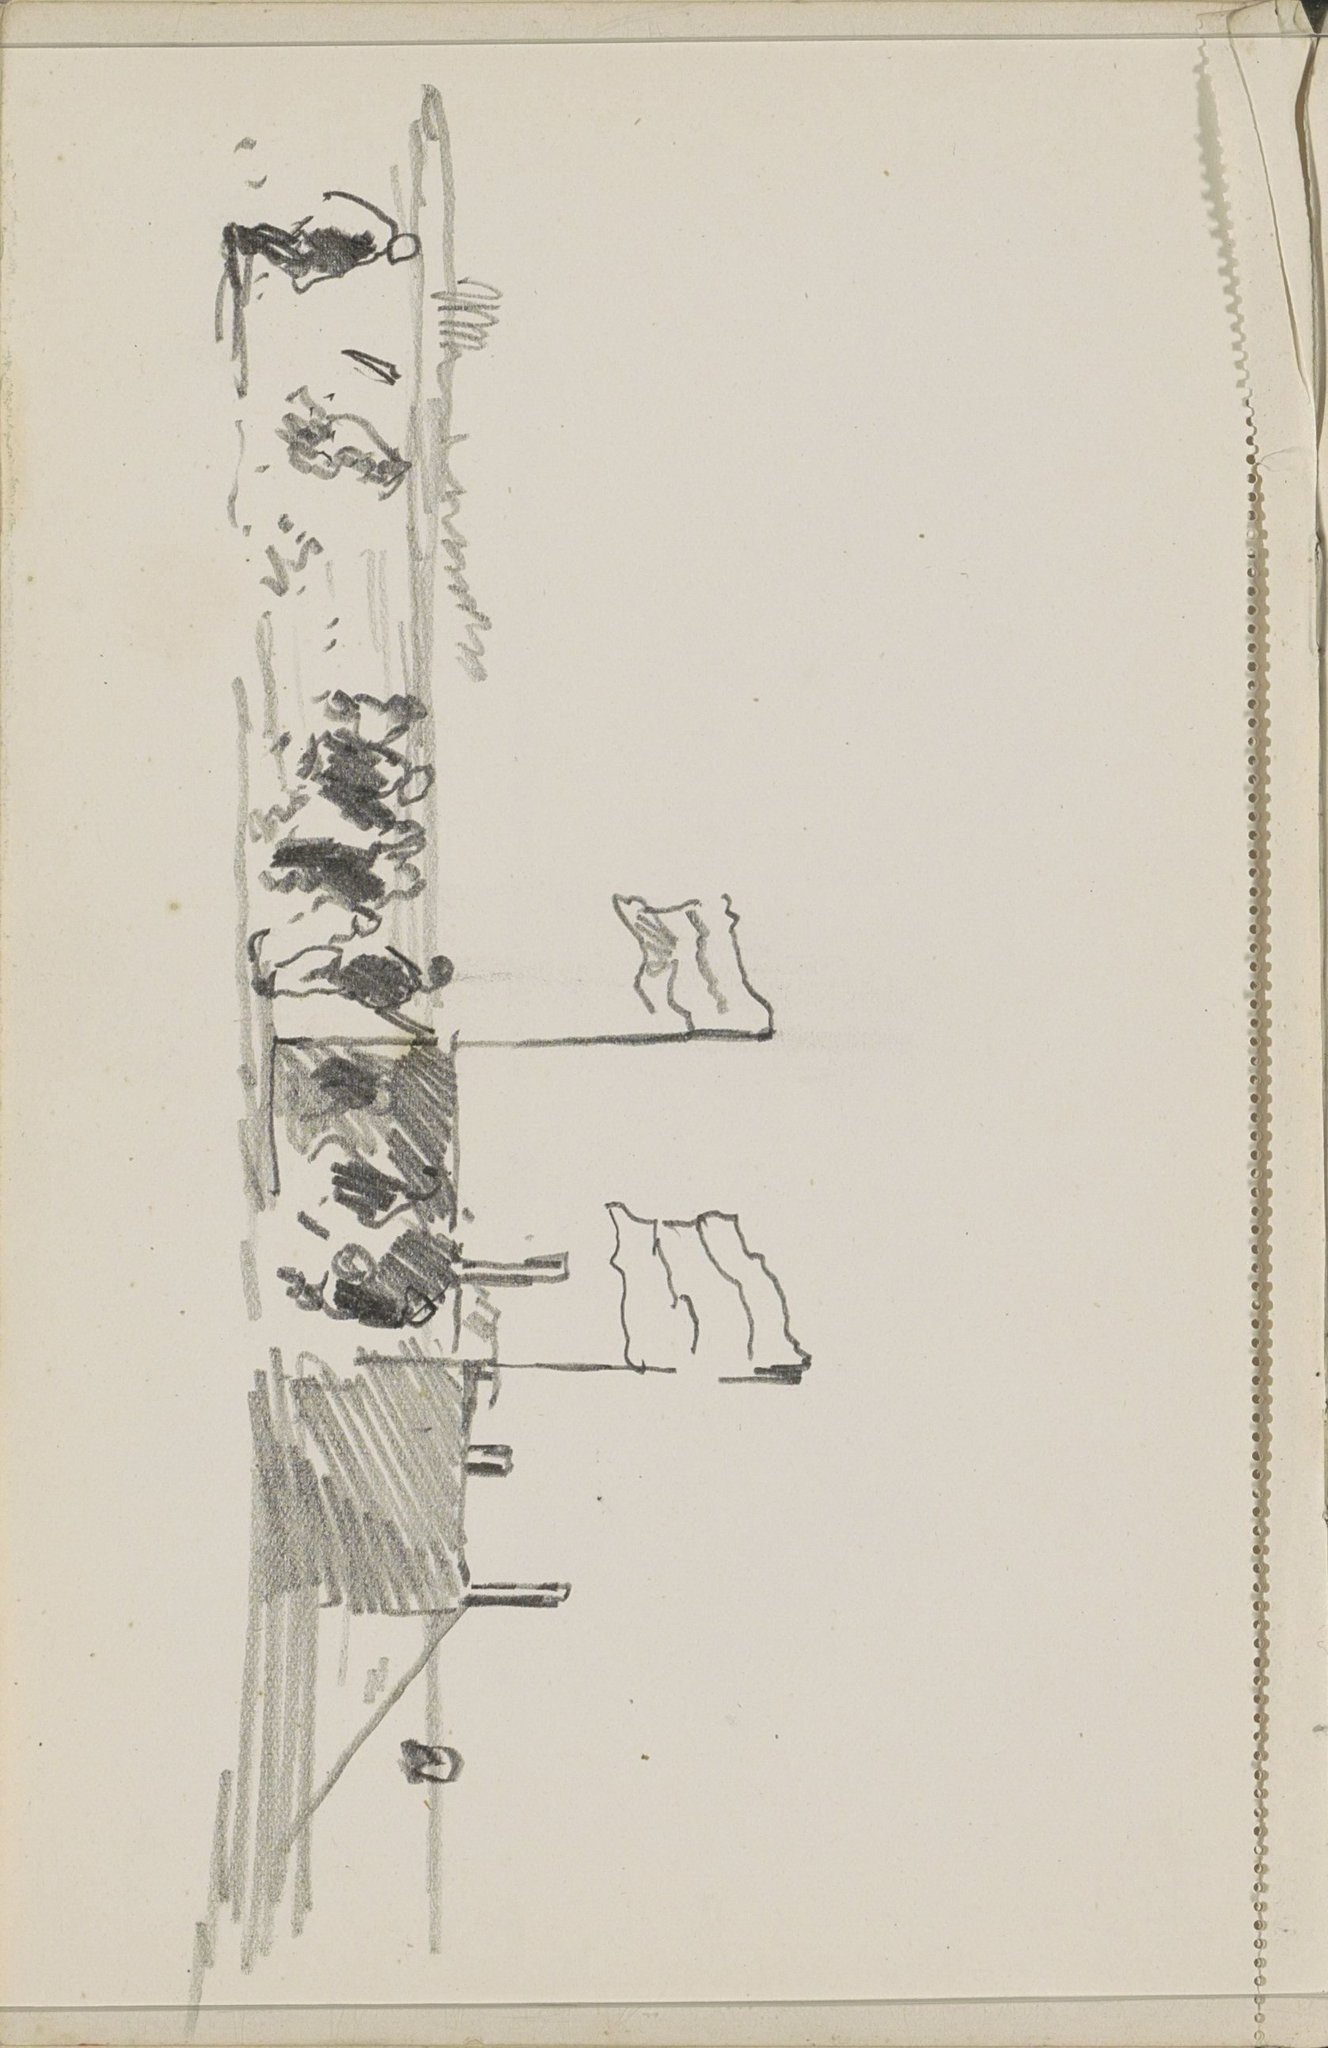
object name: sketchbook leaf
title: Landschap met figuren bij een hut met twee vlaggen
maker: cornelis vreedenburgh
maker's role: draughtsman, print maker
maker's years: 1880-1946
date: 1890-1946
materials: paper, pencil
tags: flags flown from a mast, landscapes (+ landscape with figures, staffage)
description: Blad 56 verso uit een schetsboek met 61 bladen.